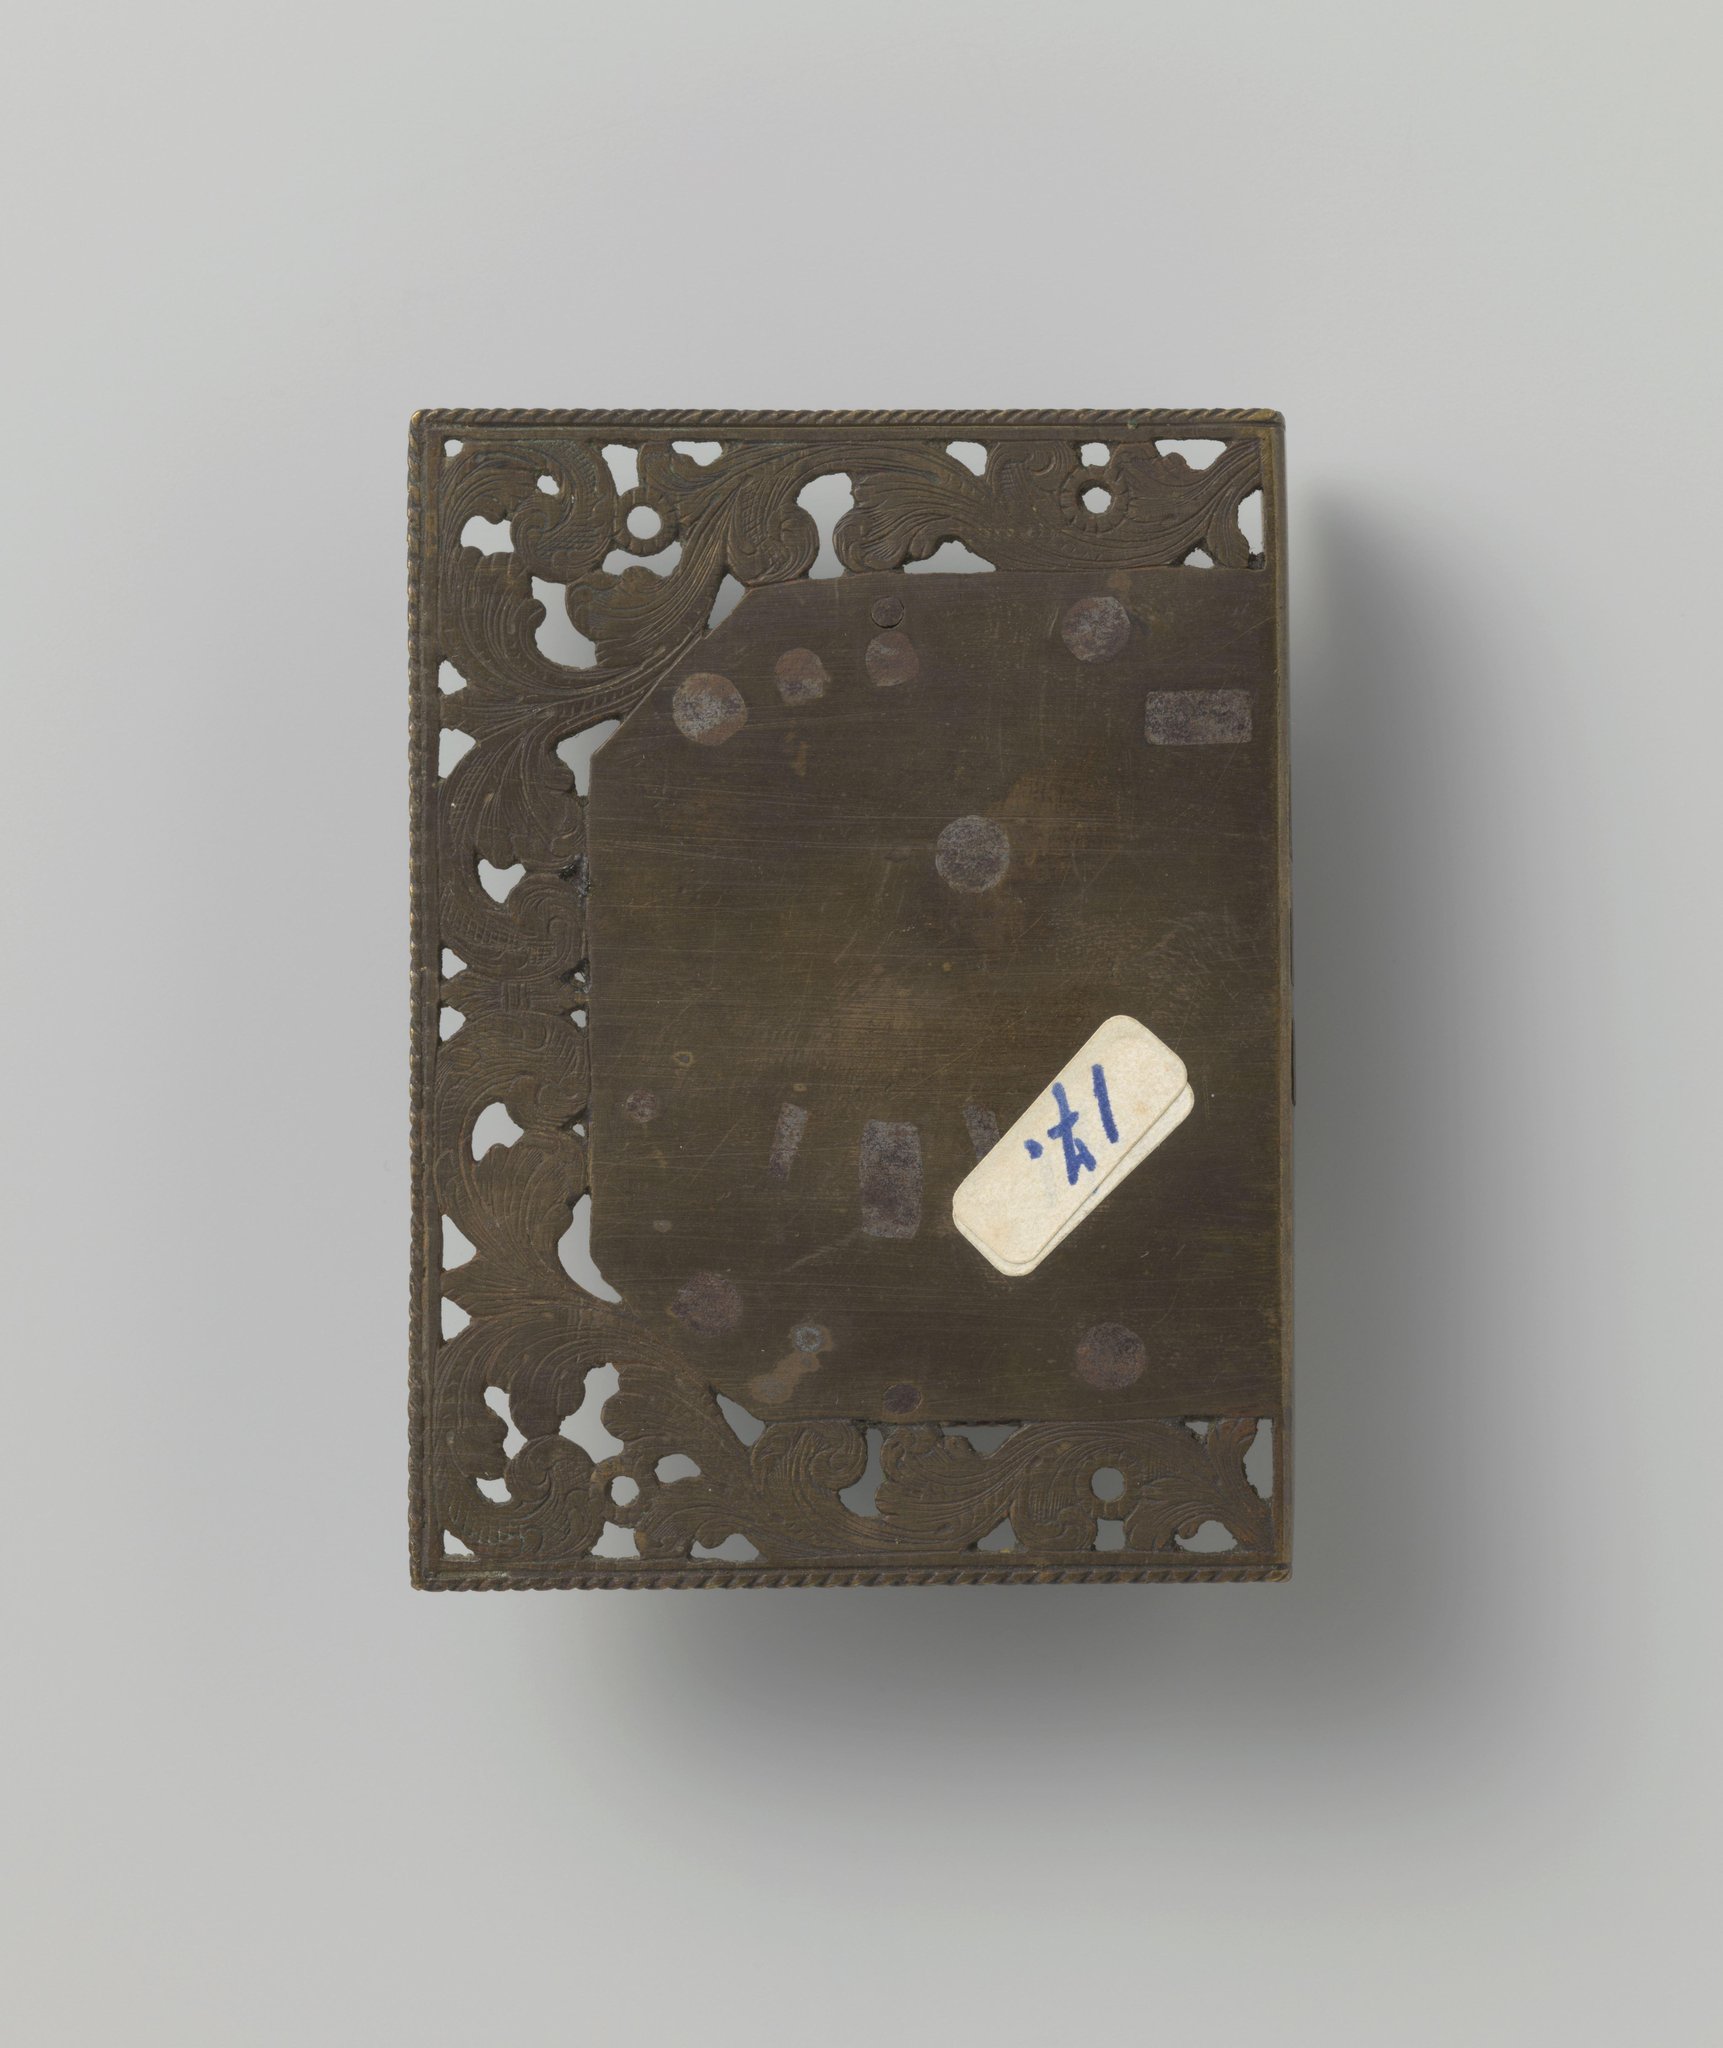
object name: lock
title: Kastdeurslot van koper en ijzer, versierd met acanthusbladeren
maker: Anonymous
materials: copper, iron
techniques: engraving, sawing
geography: western europe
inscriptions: inscription: ‘P M B 1746’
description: Rechthoekig kastdeurslot met voor- en achterplaat van koper, het slotmechanisme is van ijzer. De voorplaat is aan drie zijden opengewerkt en versierd met acanthusbladeren. De achterzijde heeft een sleutelgat met de ijzeren sleutelpen in het midden. De randen van de sleutelplaat aan de voor- en achterzijde zijn omringd met een smalle touwachtige rand. Tussen de voor- en achterplaat is een opengewerkte, opstaande rand geplaatst.